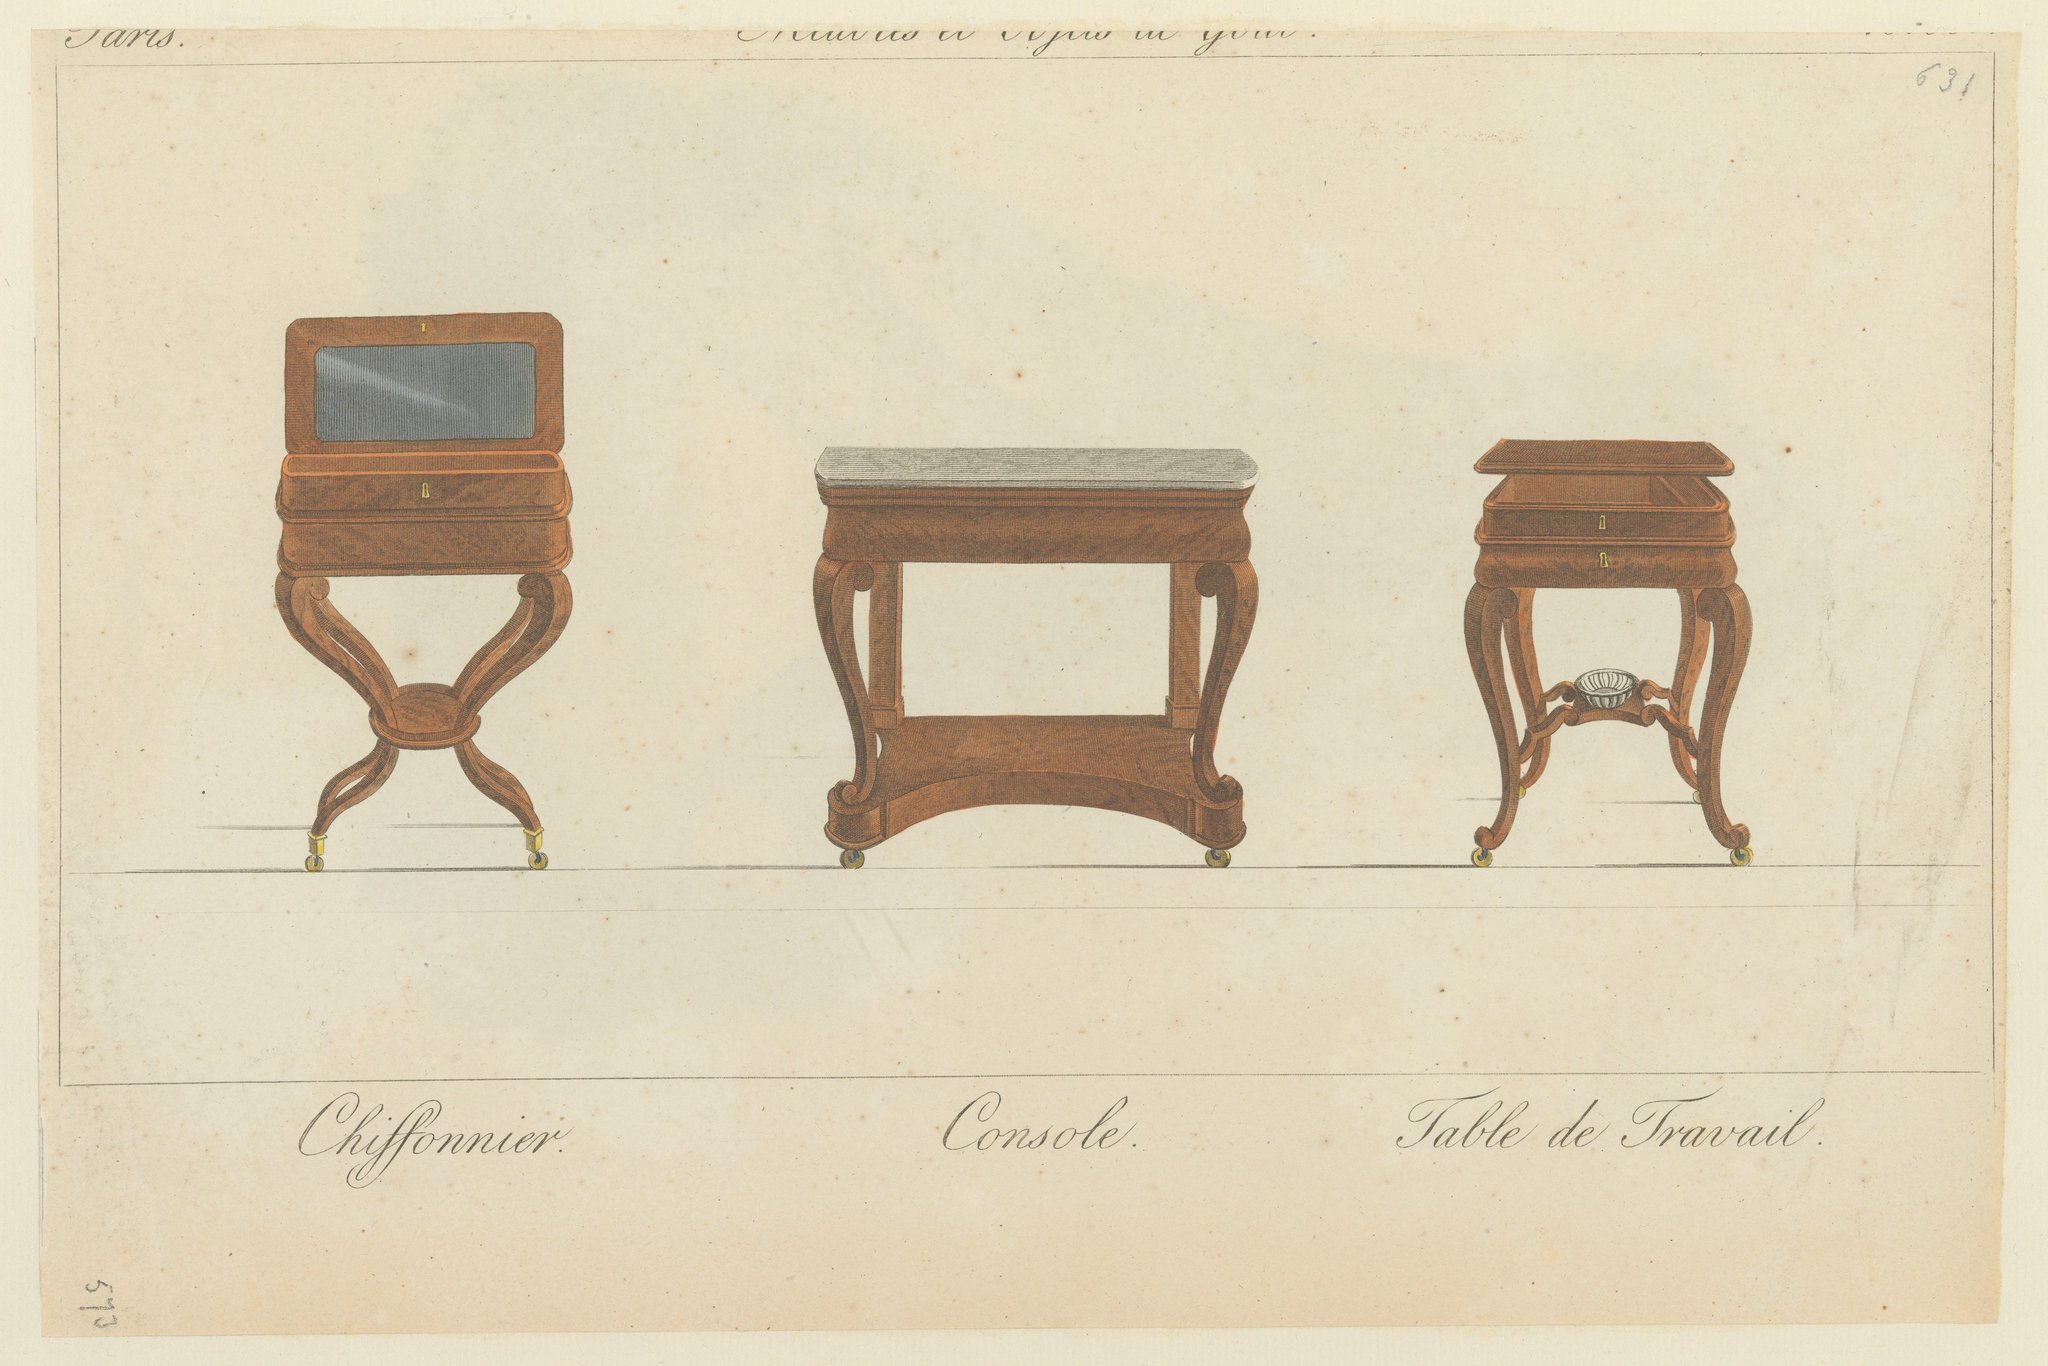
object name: book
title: Collection de Meubles et Objets de Goût, vol. 3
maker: pierre de la mésangère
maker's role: editor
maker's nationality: french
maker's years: 1761-1831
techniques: engraving, hand coloring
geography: france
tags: furniture